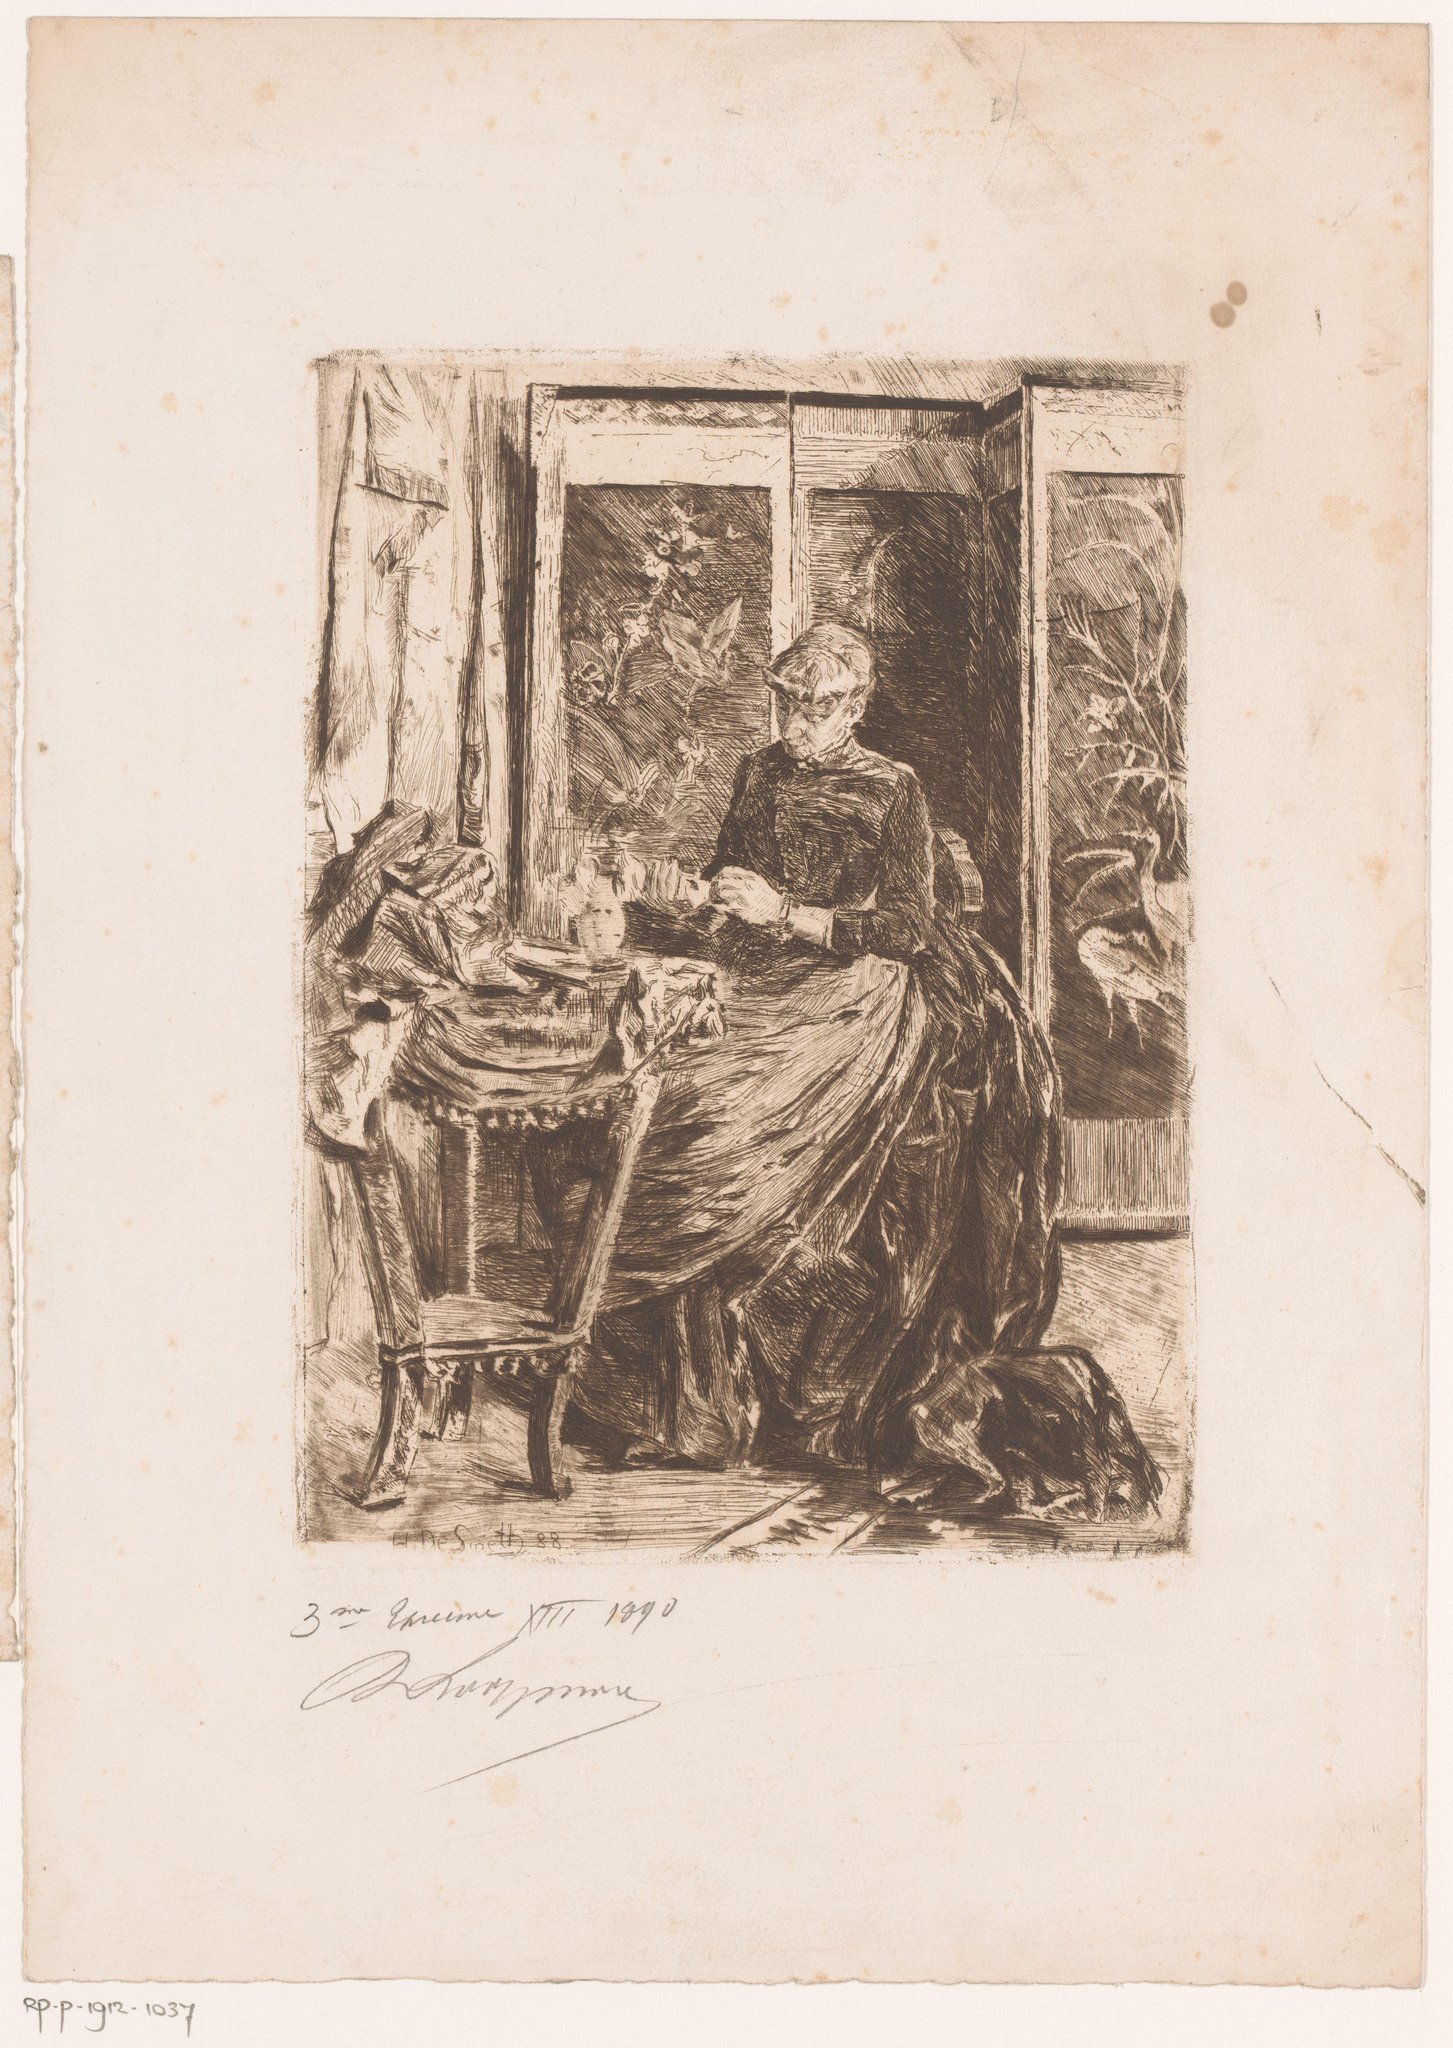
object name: print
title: Handwerkende vrouw in een interieur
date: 1890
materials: paper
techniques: drypoint, etching, intaglio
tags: sewing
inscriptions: annotation: ‘3me Epreuve’, collector's mark: Lugt 2228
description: Deze prent, of mogelijk een latere staat, is gebruikt in de suite XIII, 1890. Dit was een periodieke uitgave van de kunstenaarskring Cercle des XIII.